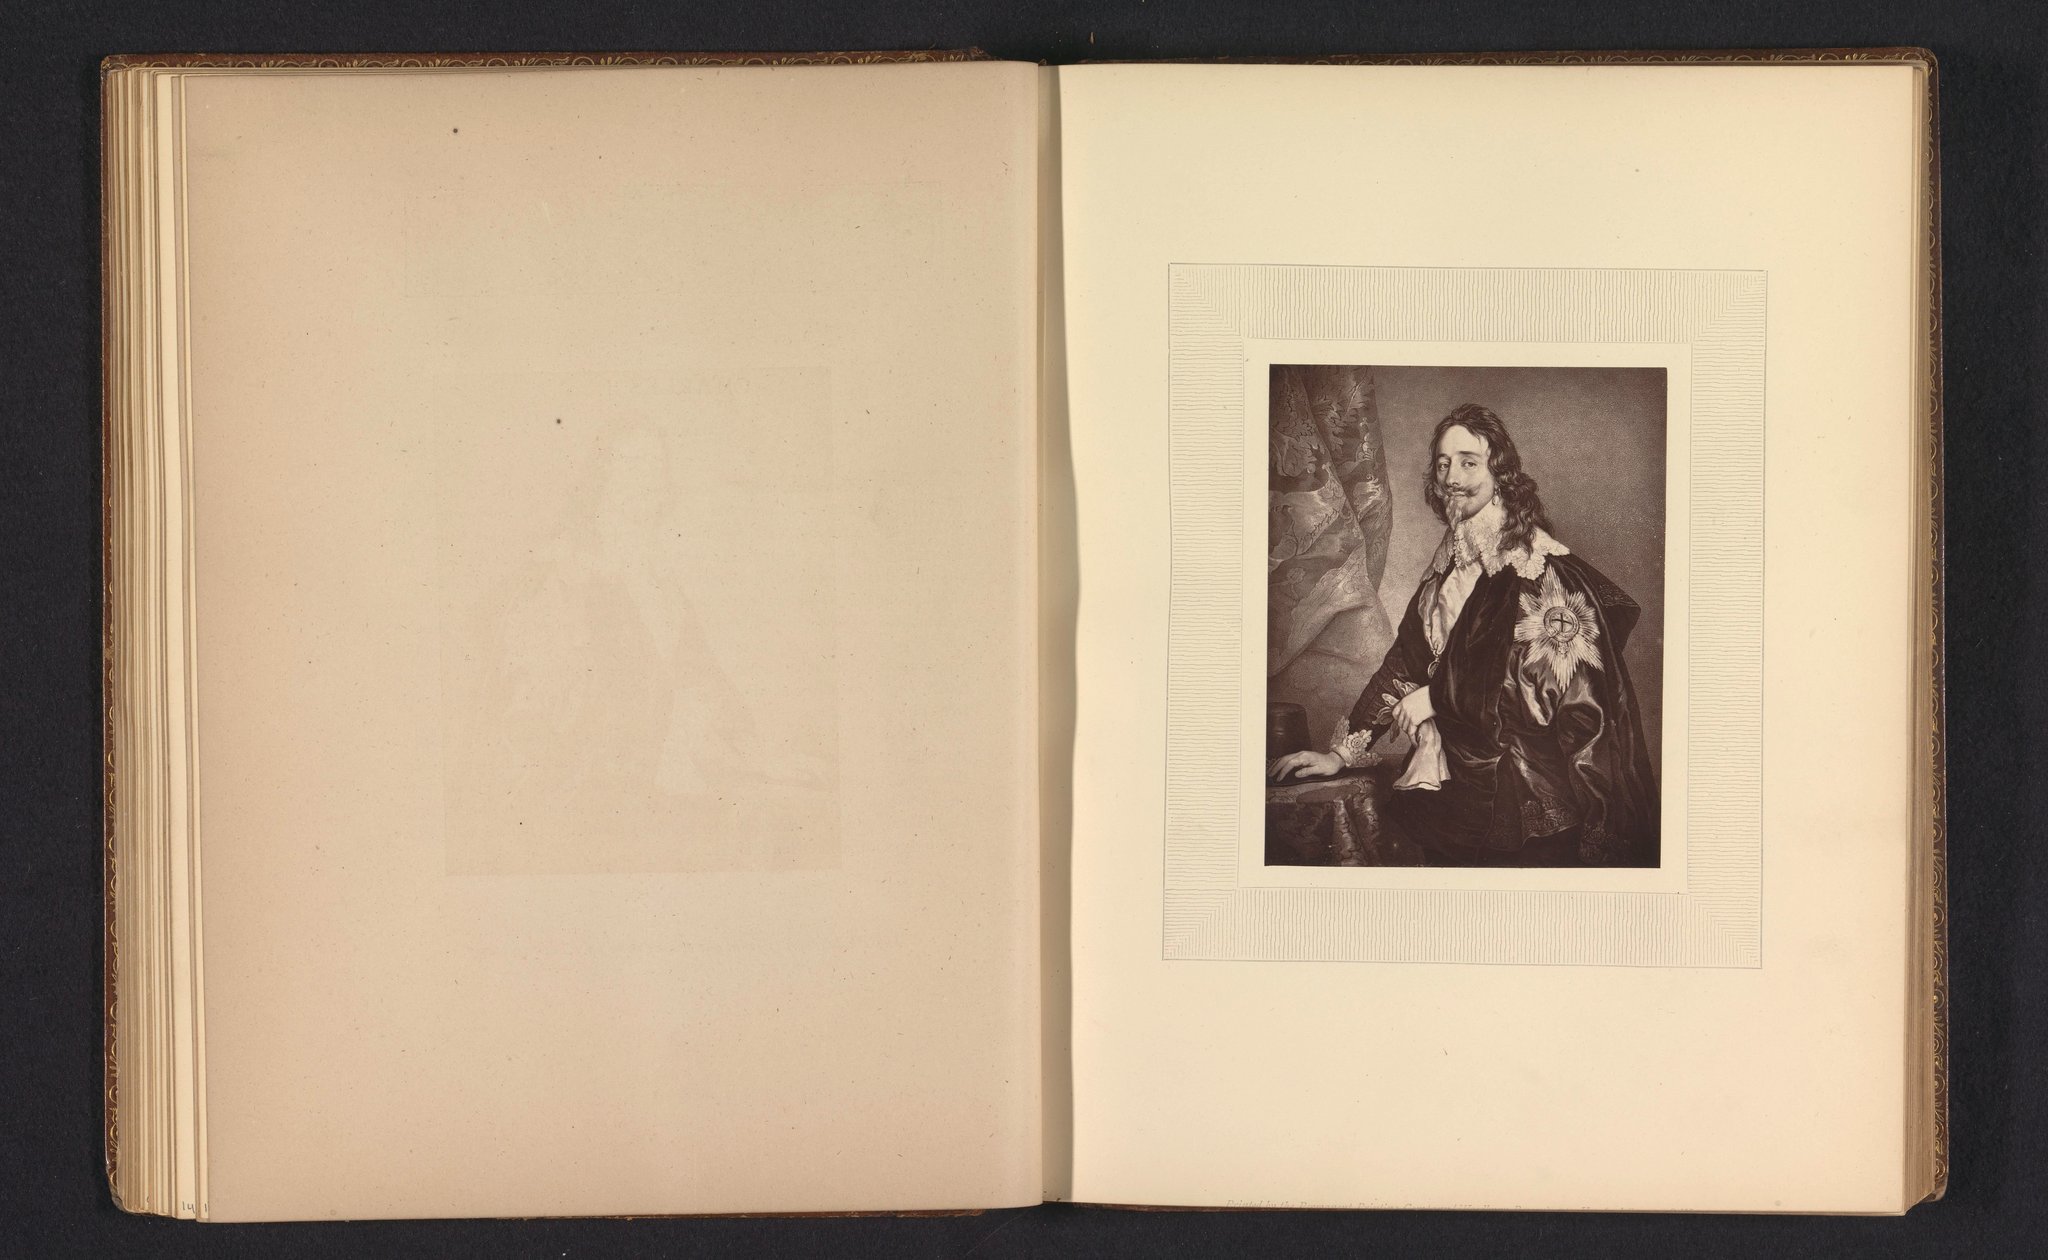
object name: page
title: Fotoreproductie van een prent naar een portret van Karel I van Engeland door Anthony van Dyck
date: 1864-1874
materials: paper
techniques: woodburytype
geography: london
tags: london, karel i (koning van engeland), ruler, sovereign, picture, painting